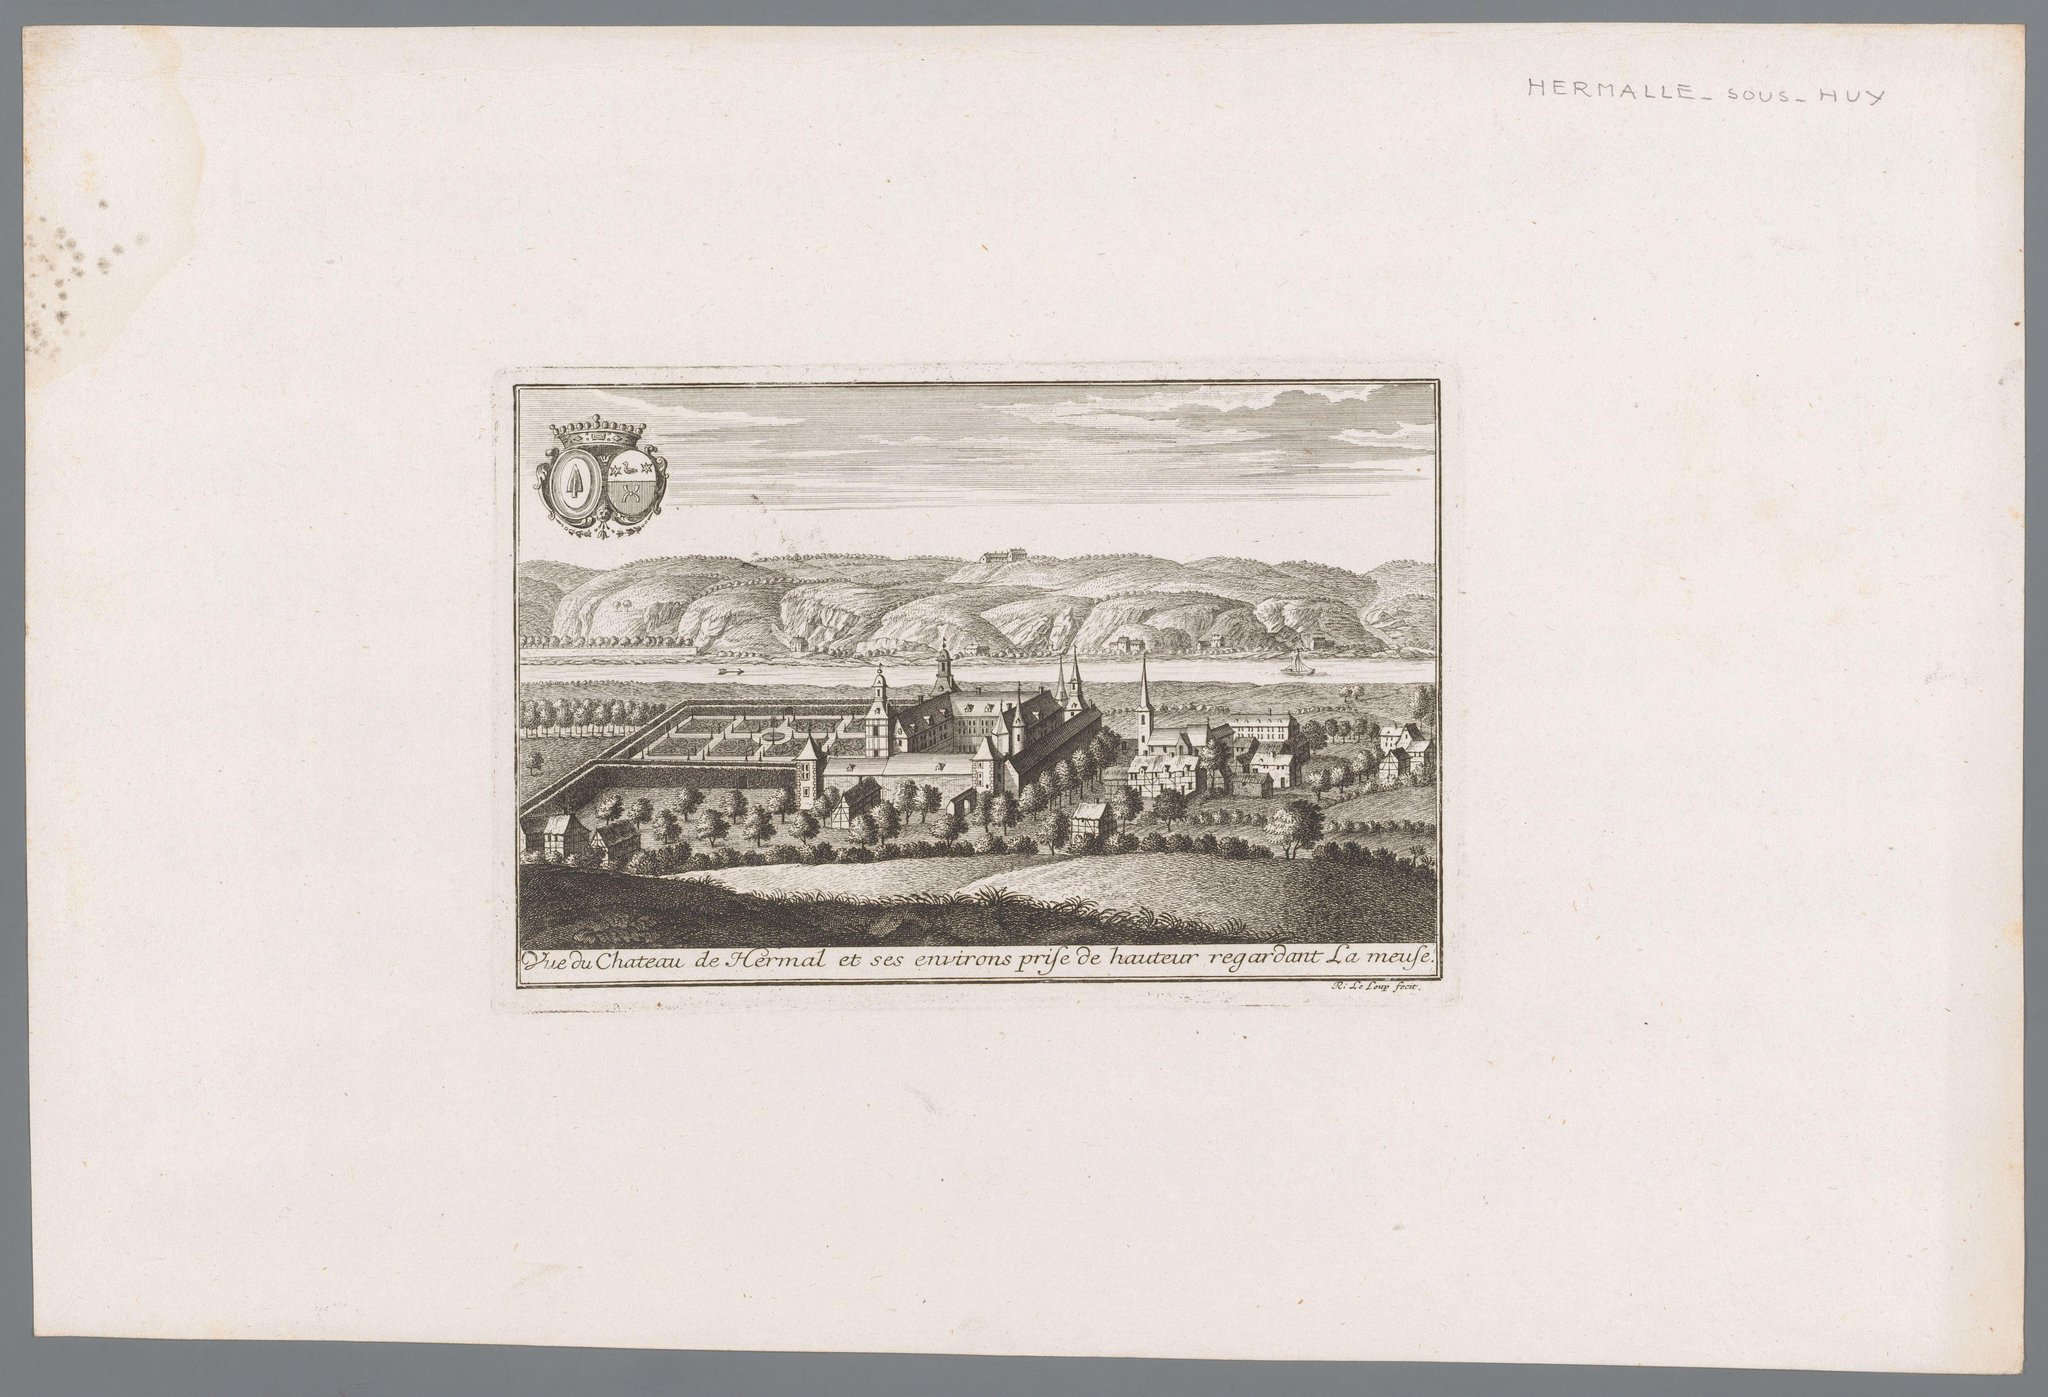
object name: print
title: Gezicht op het Kasteel van Hermalle-sous-Huy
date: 1738-1744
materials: paper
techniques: engraving, etching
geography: liège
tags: castle, landscape with tower or castle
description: Prent uit: Johanne de Saumery, Alexandre de et al. Les délices du païs de Liège, ou description géographique, topographique et chorographique des monumes sacrés et profanes (...). 5 dln. Luik: Everard Kints, 1738-1744, dl. 1, p. 360.